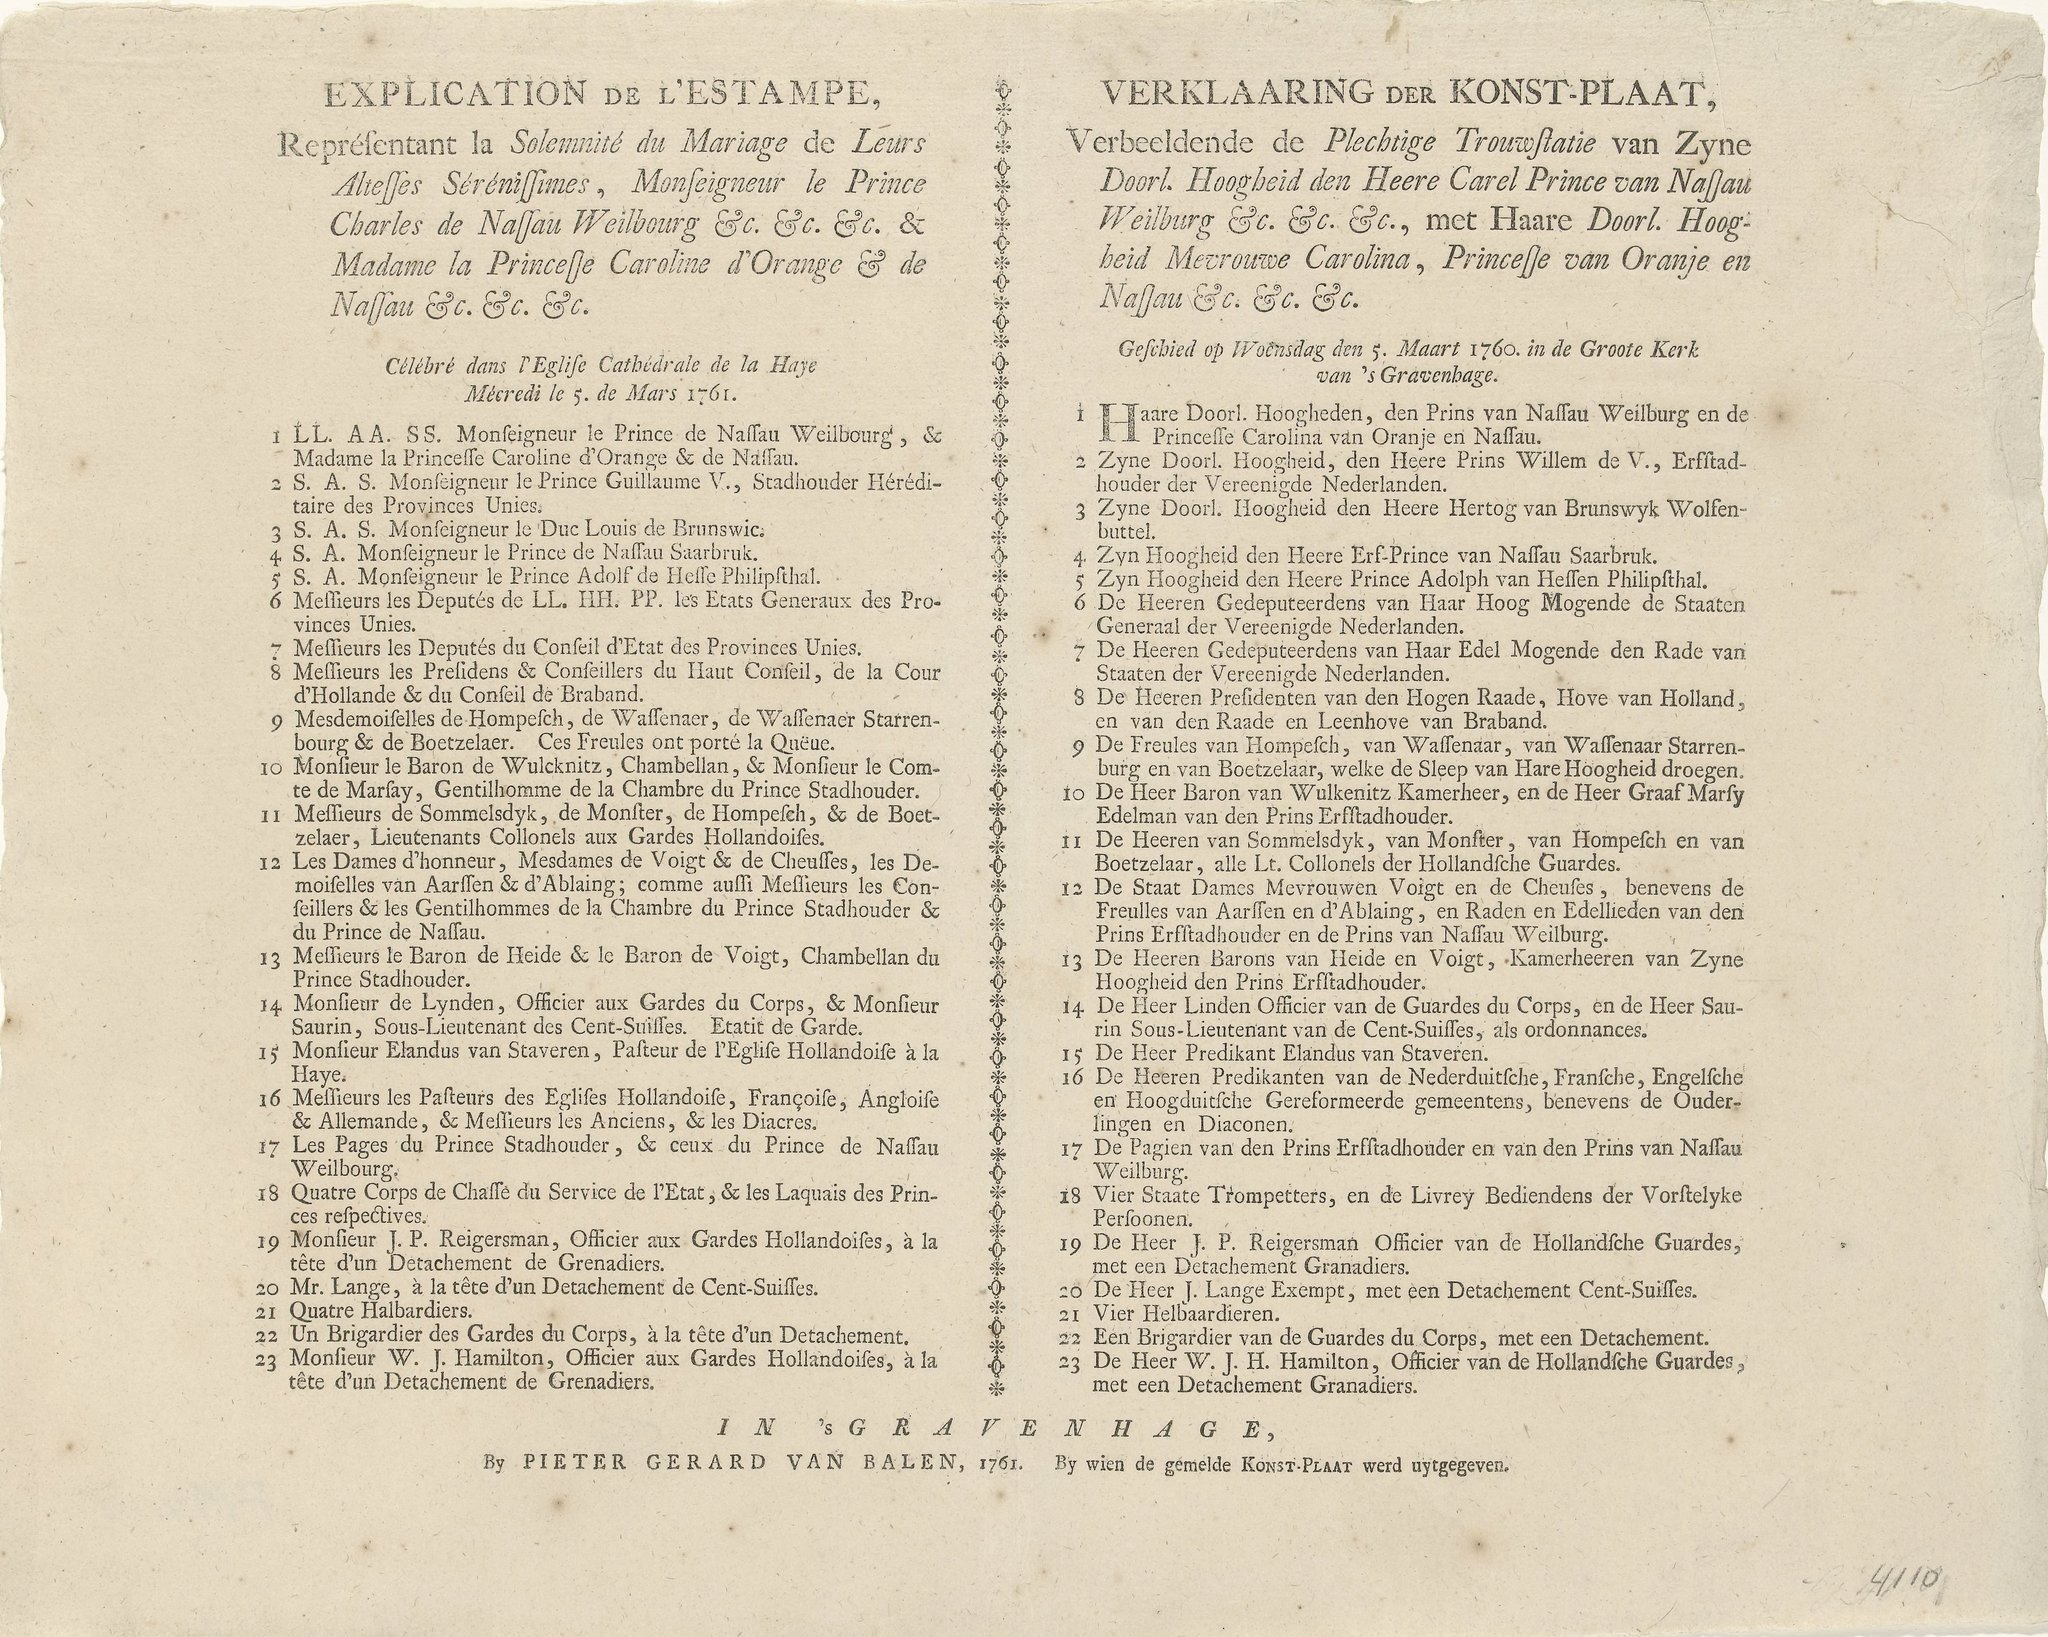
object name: text sheet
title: Explication de l'Estampe (...) / Verklaaring der Konst-Plaat, Verbeeldende de Plechtige Trouwstatie van (...) Carel prince van Nassau Weilburg (...) met (...) Mevrouwe Carolina, Princesse van Oranje en Nassau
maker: pieter gerard van balen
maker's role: bookseller, publisher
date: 1761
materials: paper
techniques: letterpress printing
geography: the hague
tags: william v (prince of orange), ludwig ernst von braunschweig-wolfenbüttel, carolina (prinses van oranje-nassau), karel christiaan vorst van nassau-weilburg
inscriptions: collector's mark: Lugt 2228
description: Tekstblad behorend bij de prent van de huwelijksceremonie van Karel Christiaan van Nassau-Weilburg met prinses Carolina, 5 maart 1760. Verklaring van de cijfers 1-23 in twee kolommen in het Frans en Nederlands.